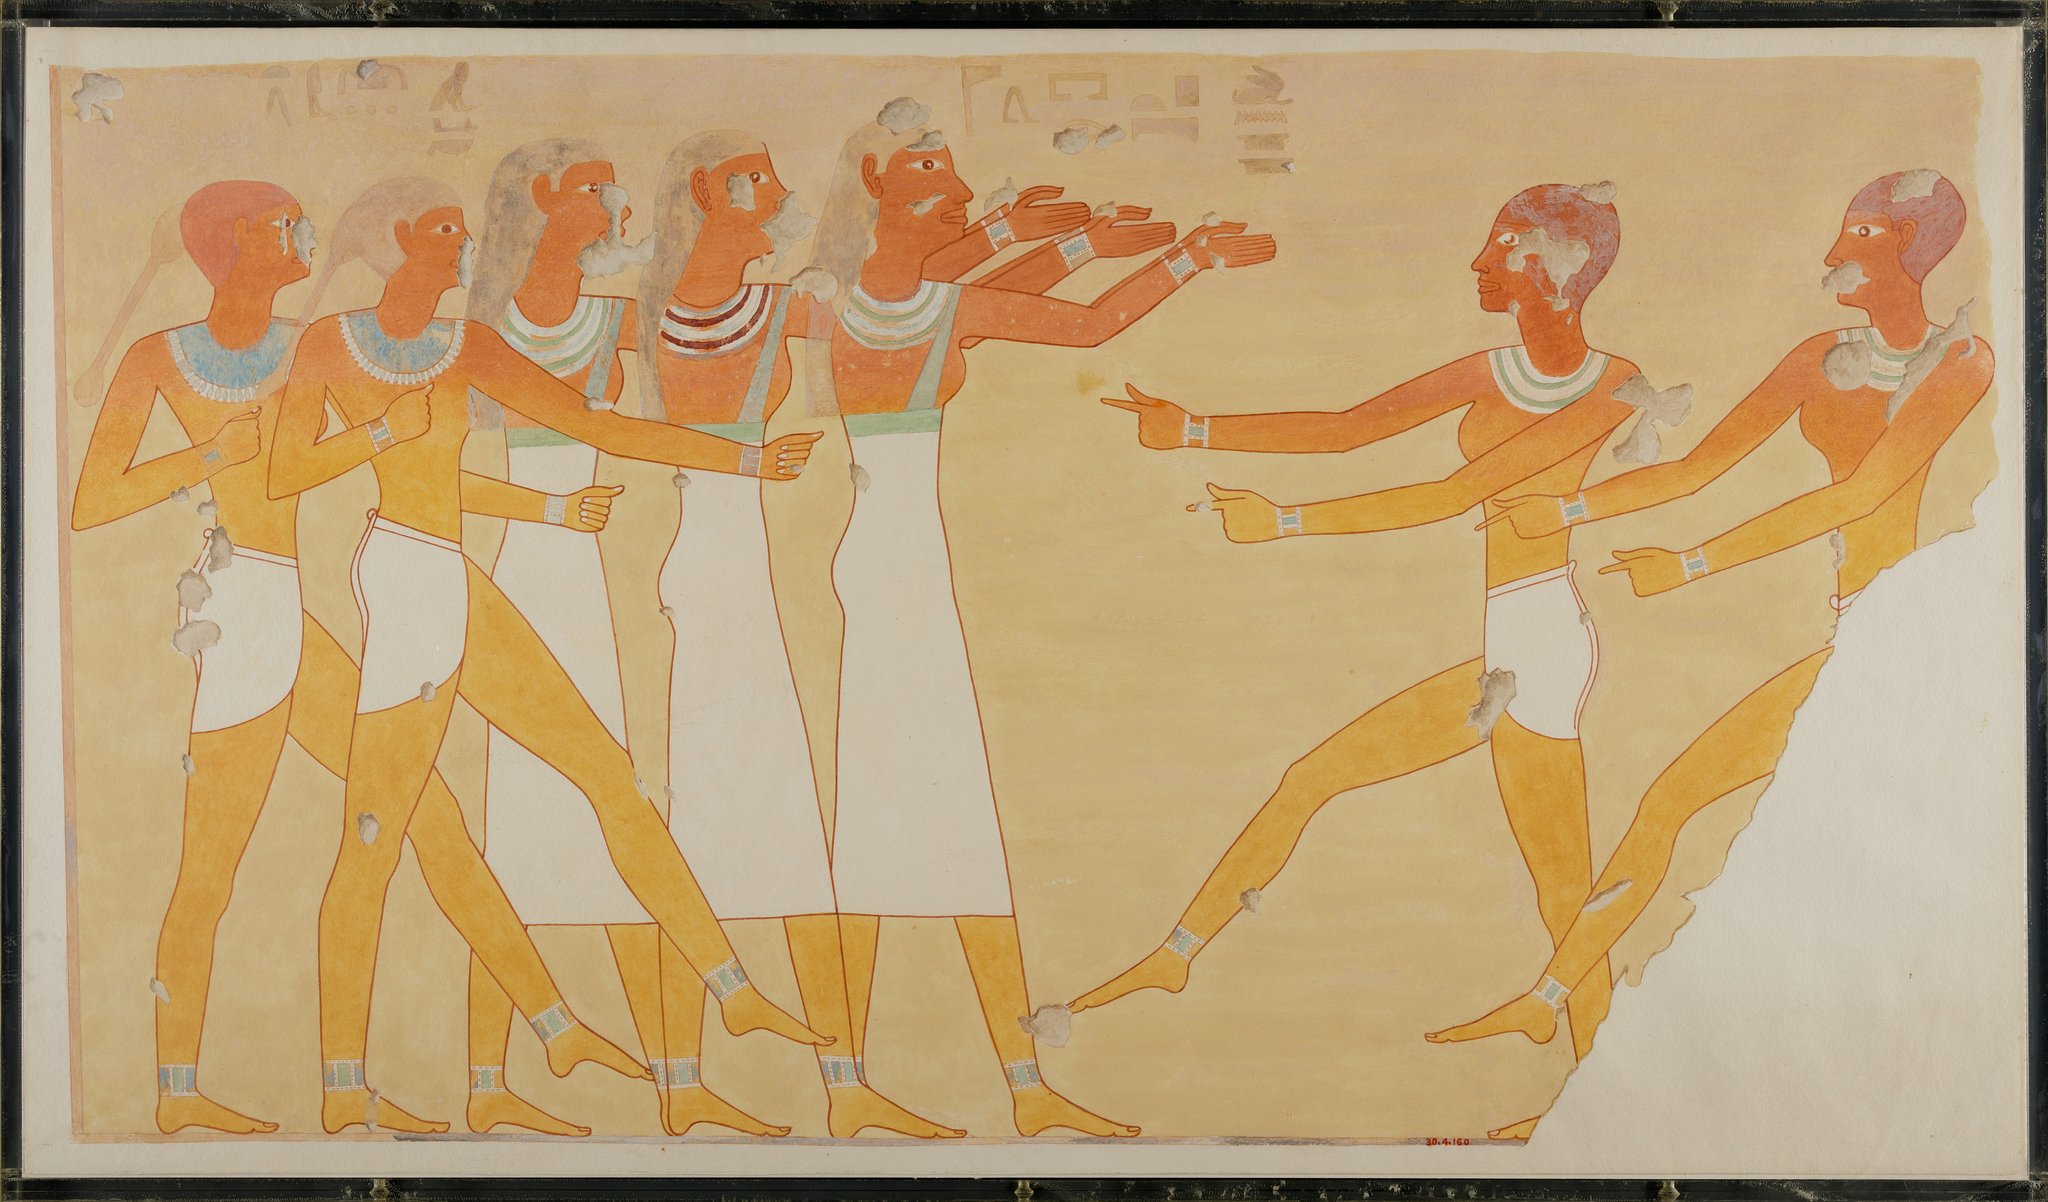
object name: facsimile, senet tt 60, intefiqer, priestess, dancer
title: Priestesses and Dancers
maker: hugh r. hopgood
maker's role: artist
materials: paper, paint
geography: egypt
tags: women,dancing,dancers